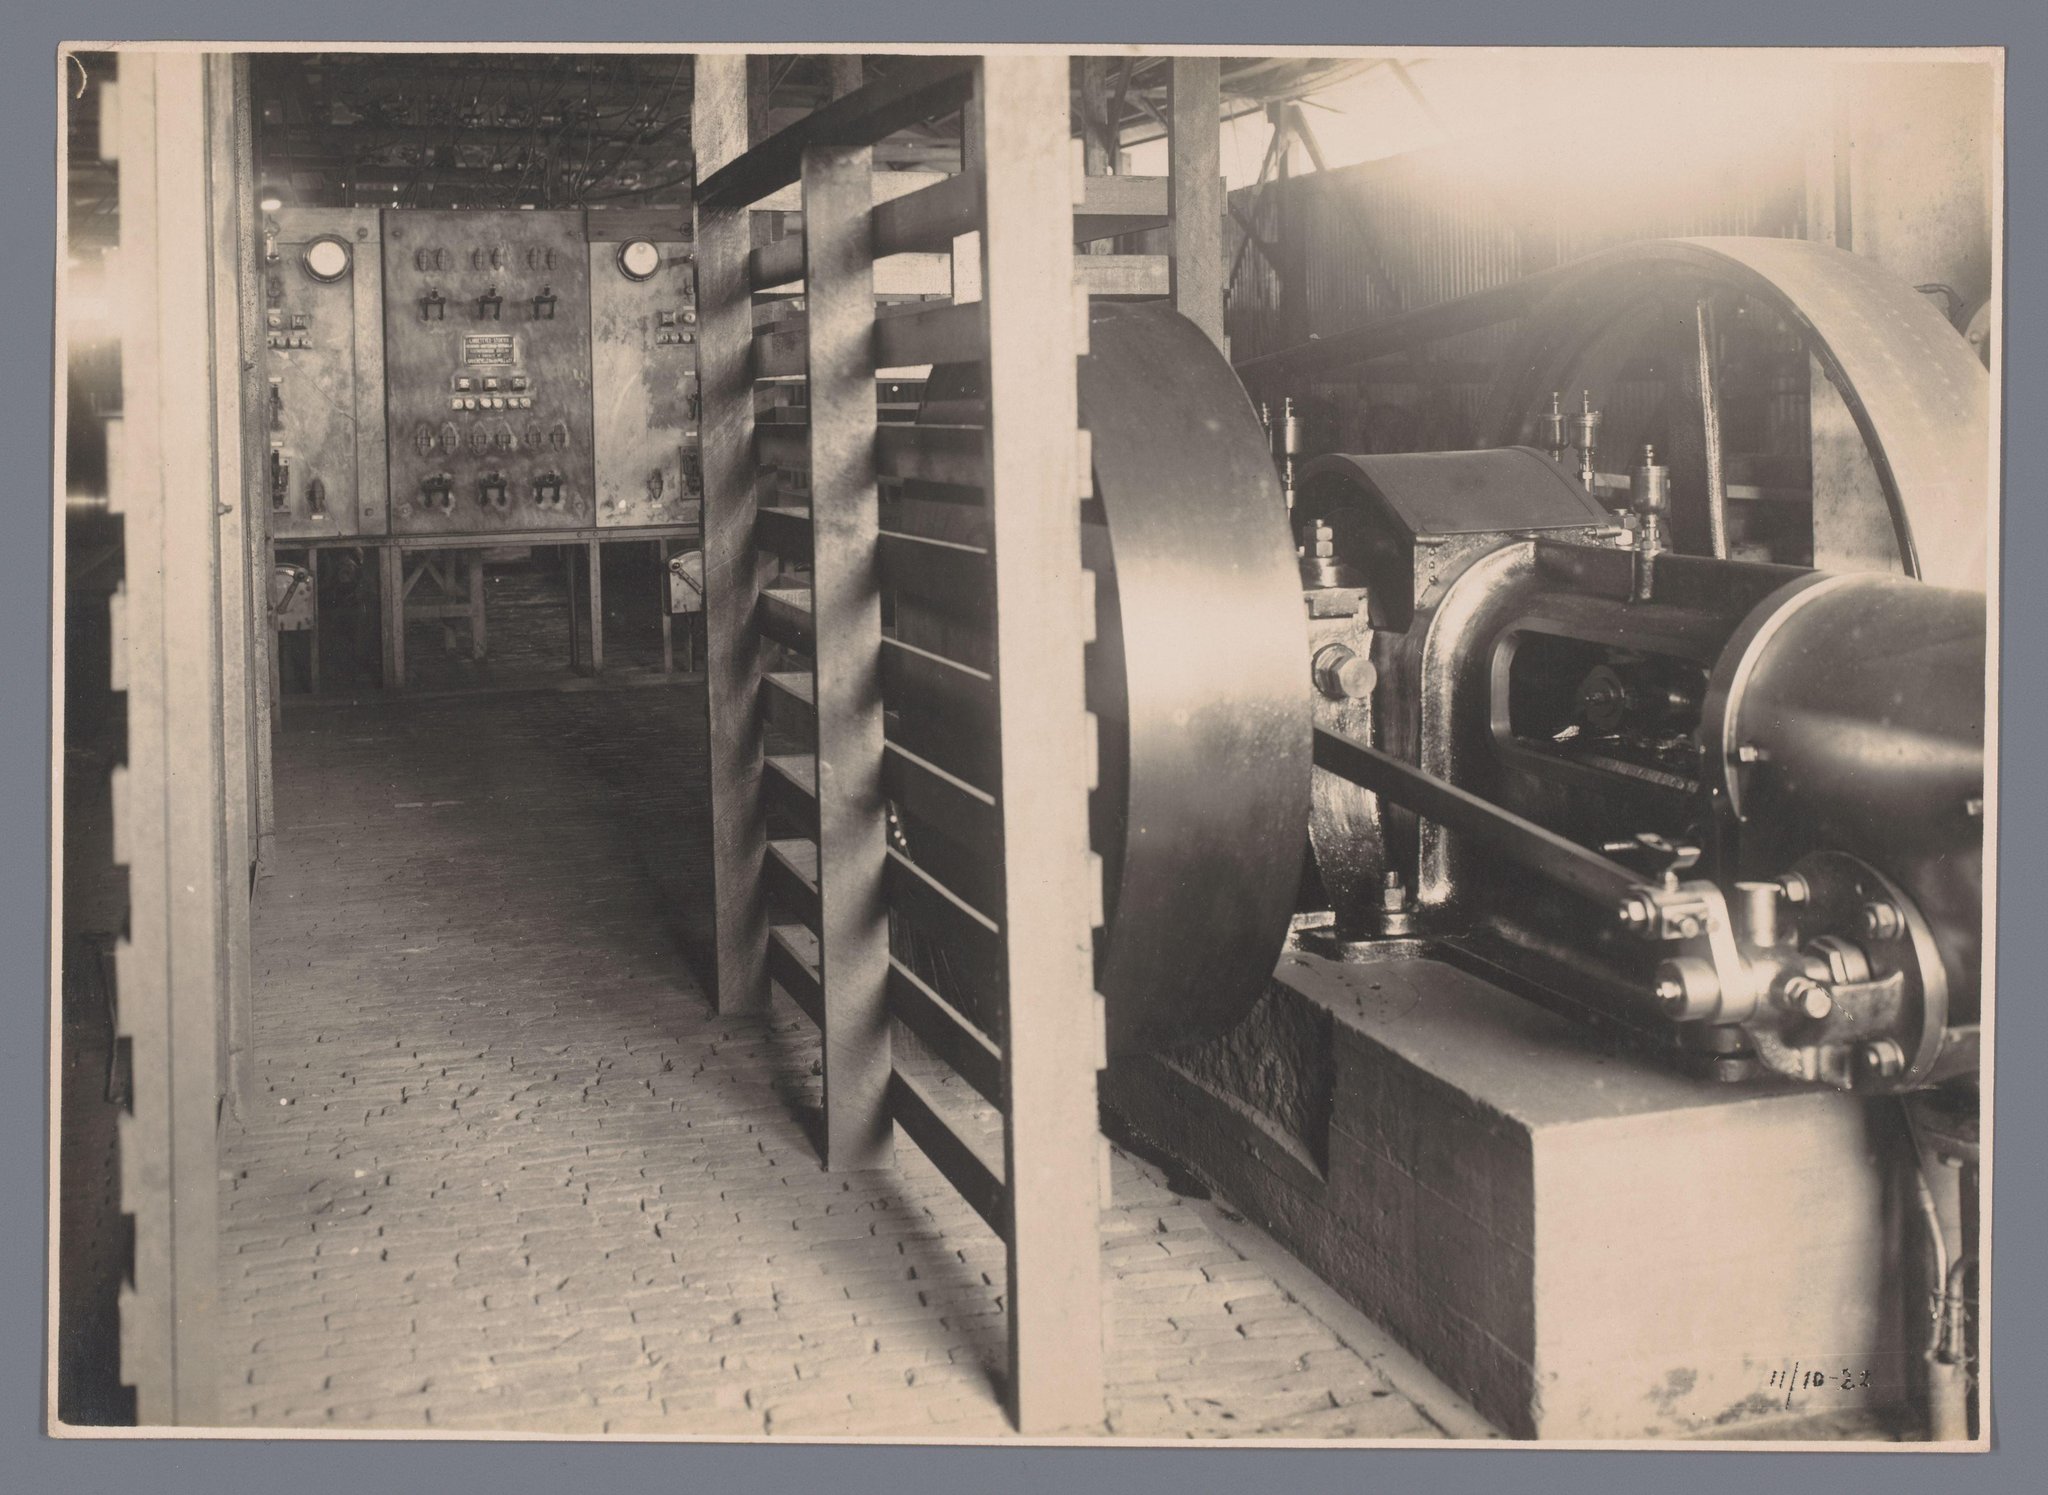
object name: photograph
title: Interieur Centrale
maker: Anonymous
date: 1922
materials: photographic support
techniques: gelatin silver print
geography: belawan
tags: factory-interior, machine shop, machines; parts of machines; tools and appliances, building-site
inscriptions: annotation: ‘No. 253 Interieur Centrale’, date: ‘11/10-22’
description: Gezicht op de centrale in de machinehal. Genummerd: 253. Onderdeel van de groep van losse foto's over de aanleg van de haven Belawan aan de kust voor Medan, Sumatra 1921-1922.